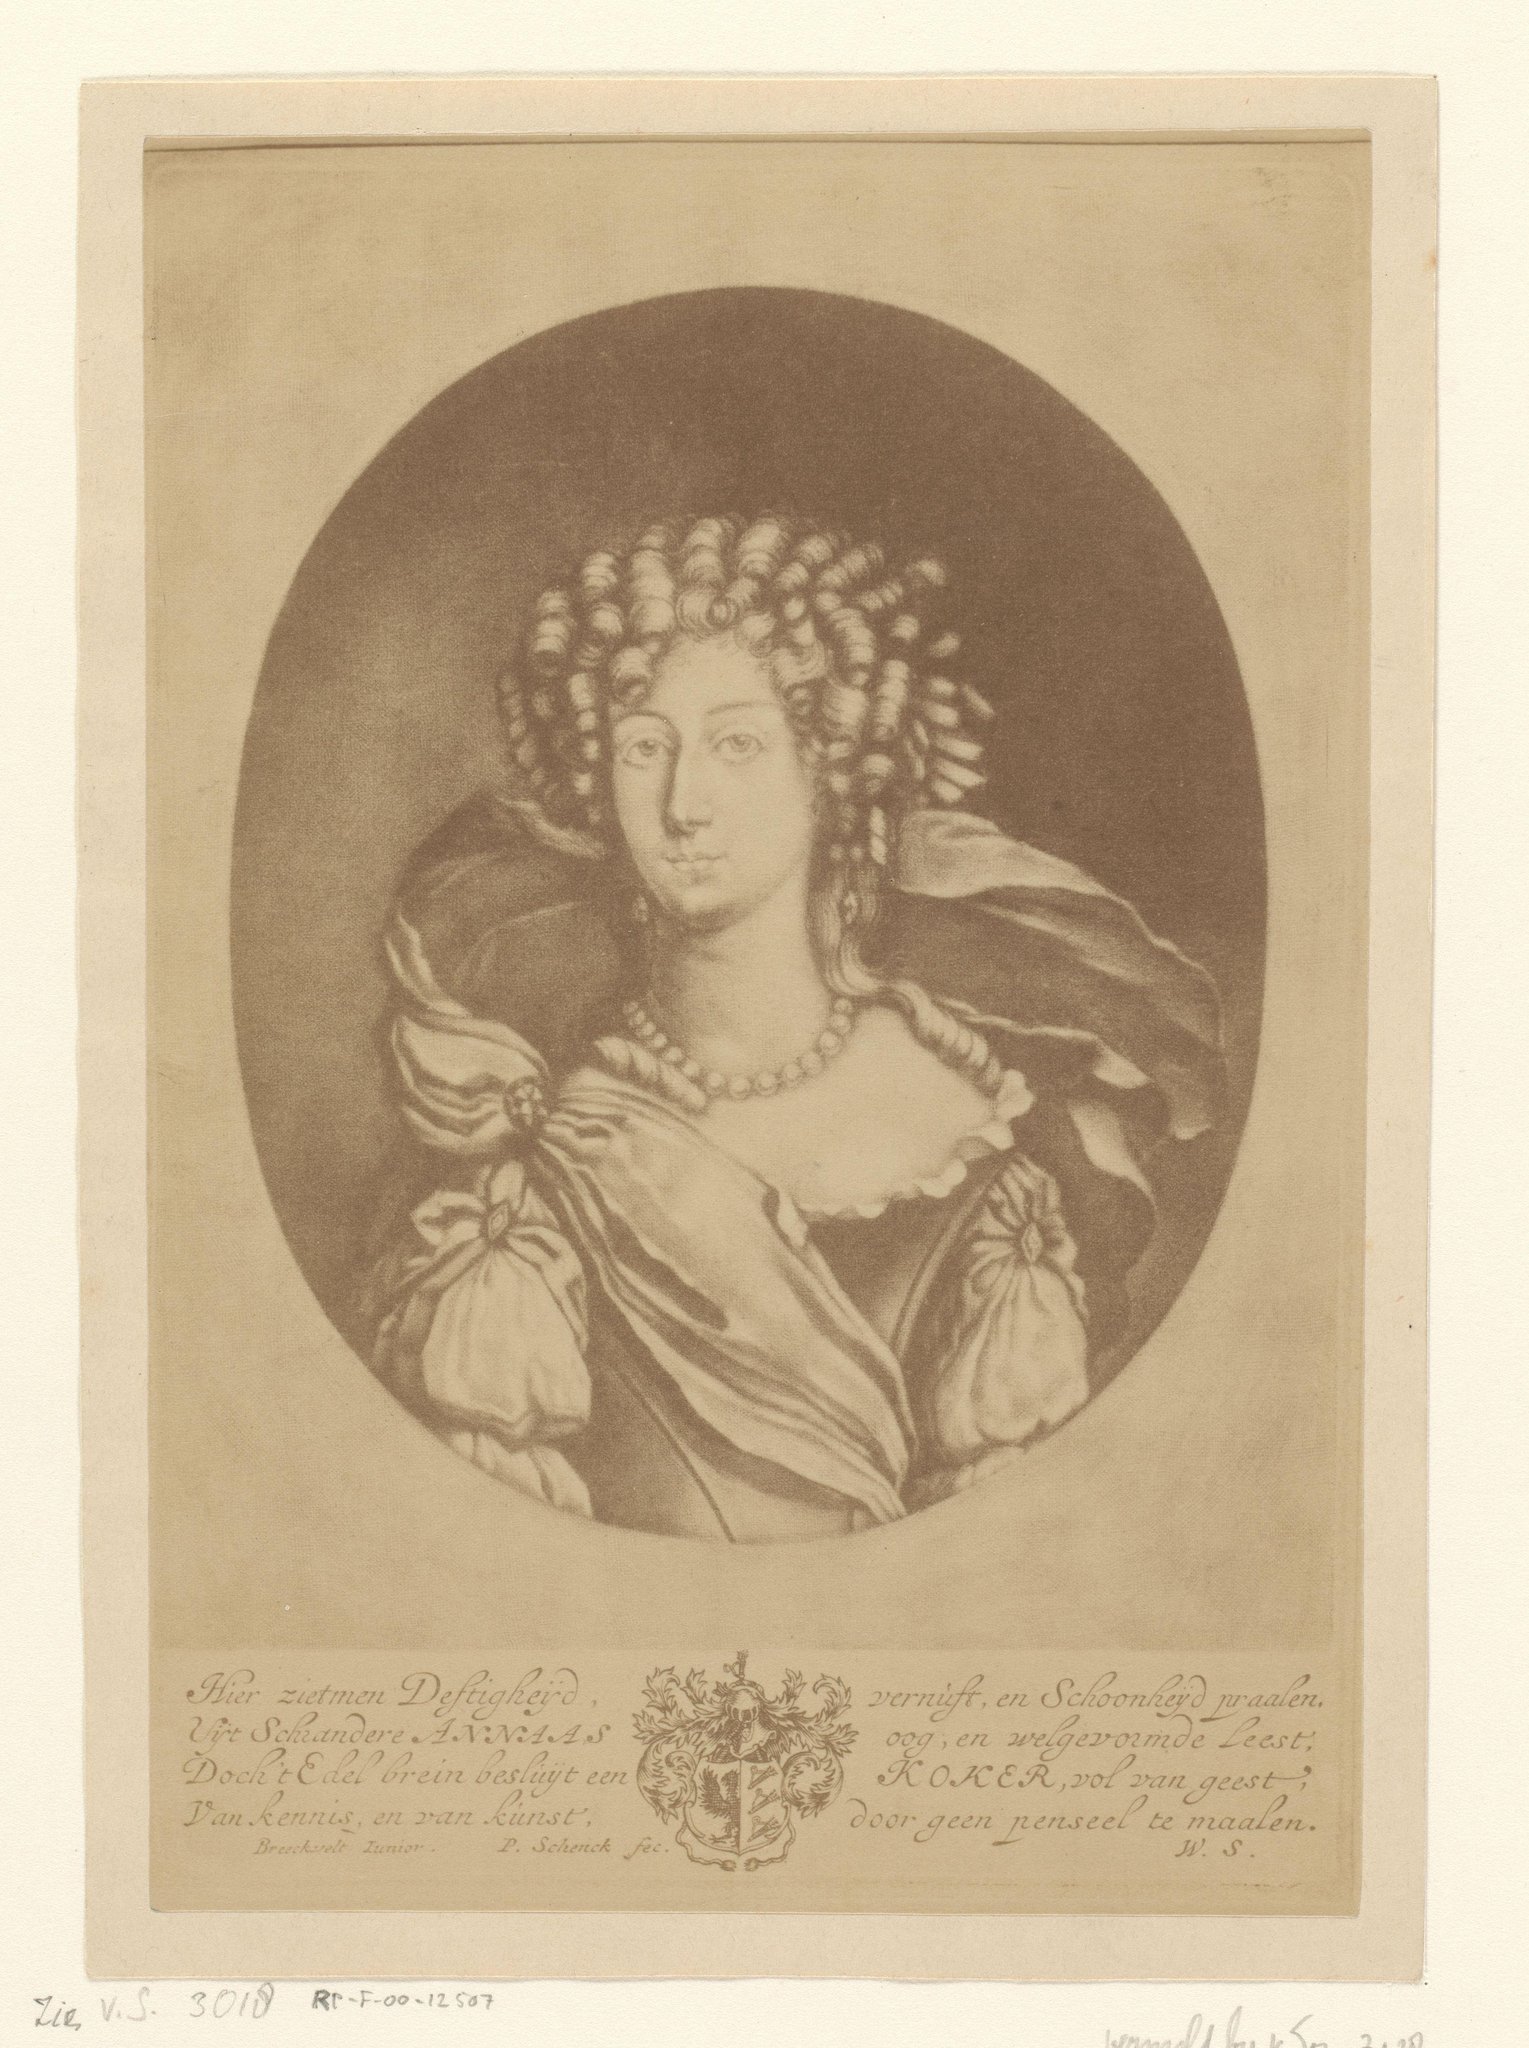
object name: reproduction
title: Fotoreproductie van een geschilderd portret van Anna Maria de Koker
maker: Anonymous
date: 1870-1890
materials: cardboard, paper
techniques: albumen print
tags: amsterdam, print maker, anna maria de koker, historical persons - bb - woman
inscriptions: collector's mark: Lugt 2760